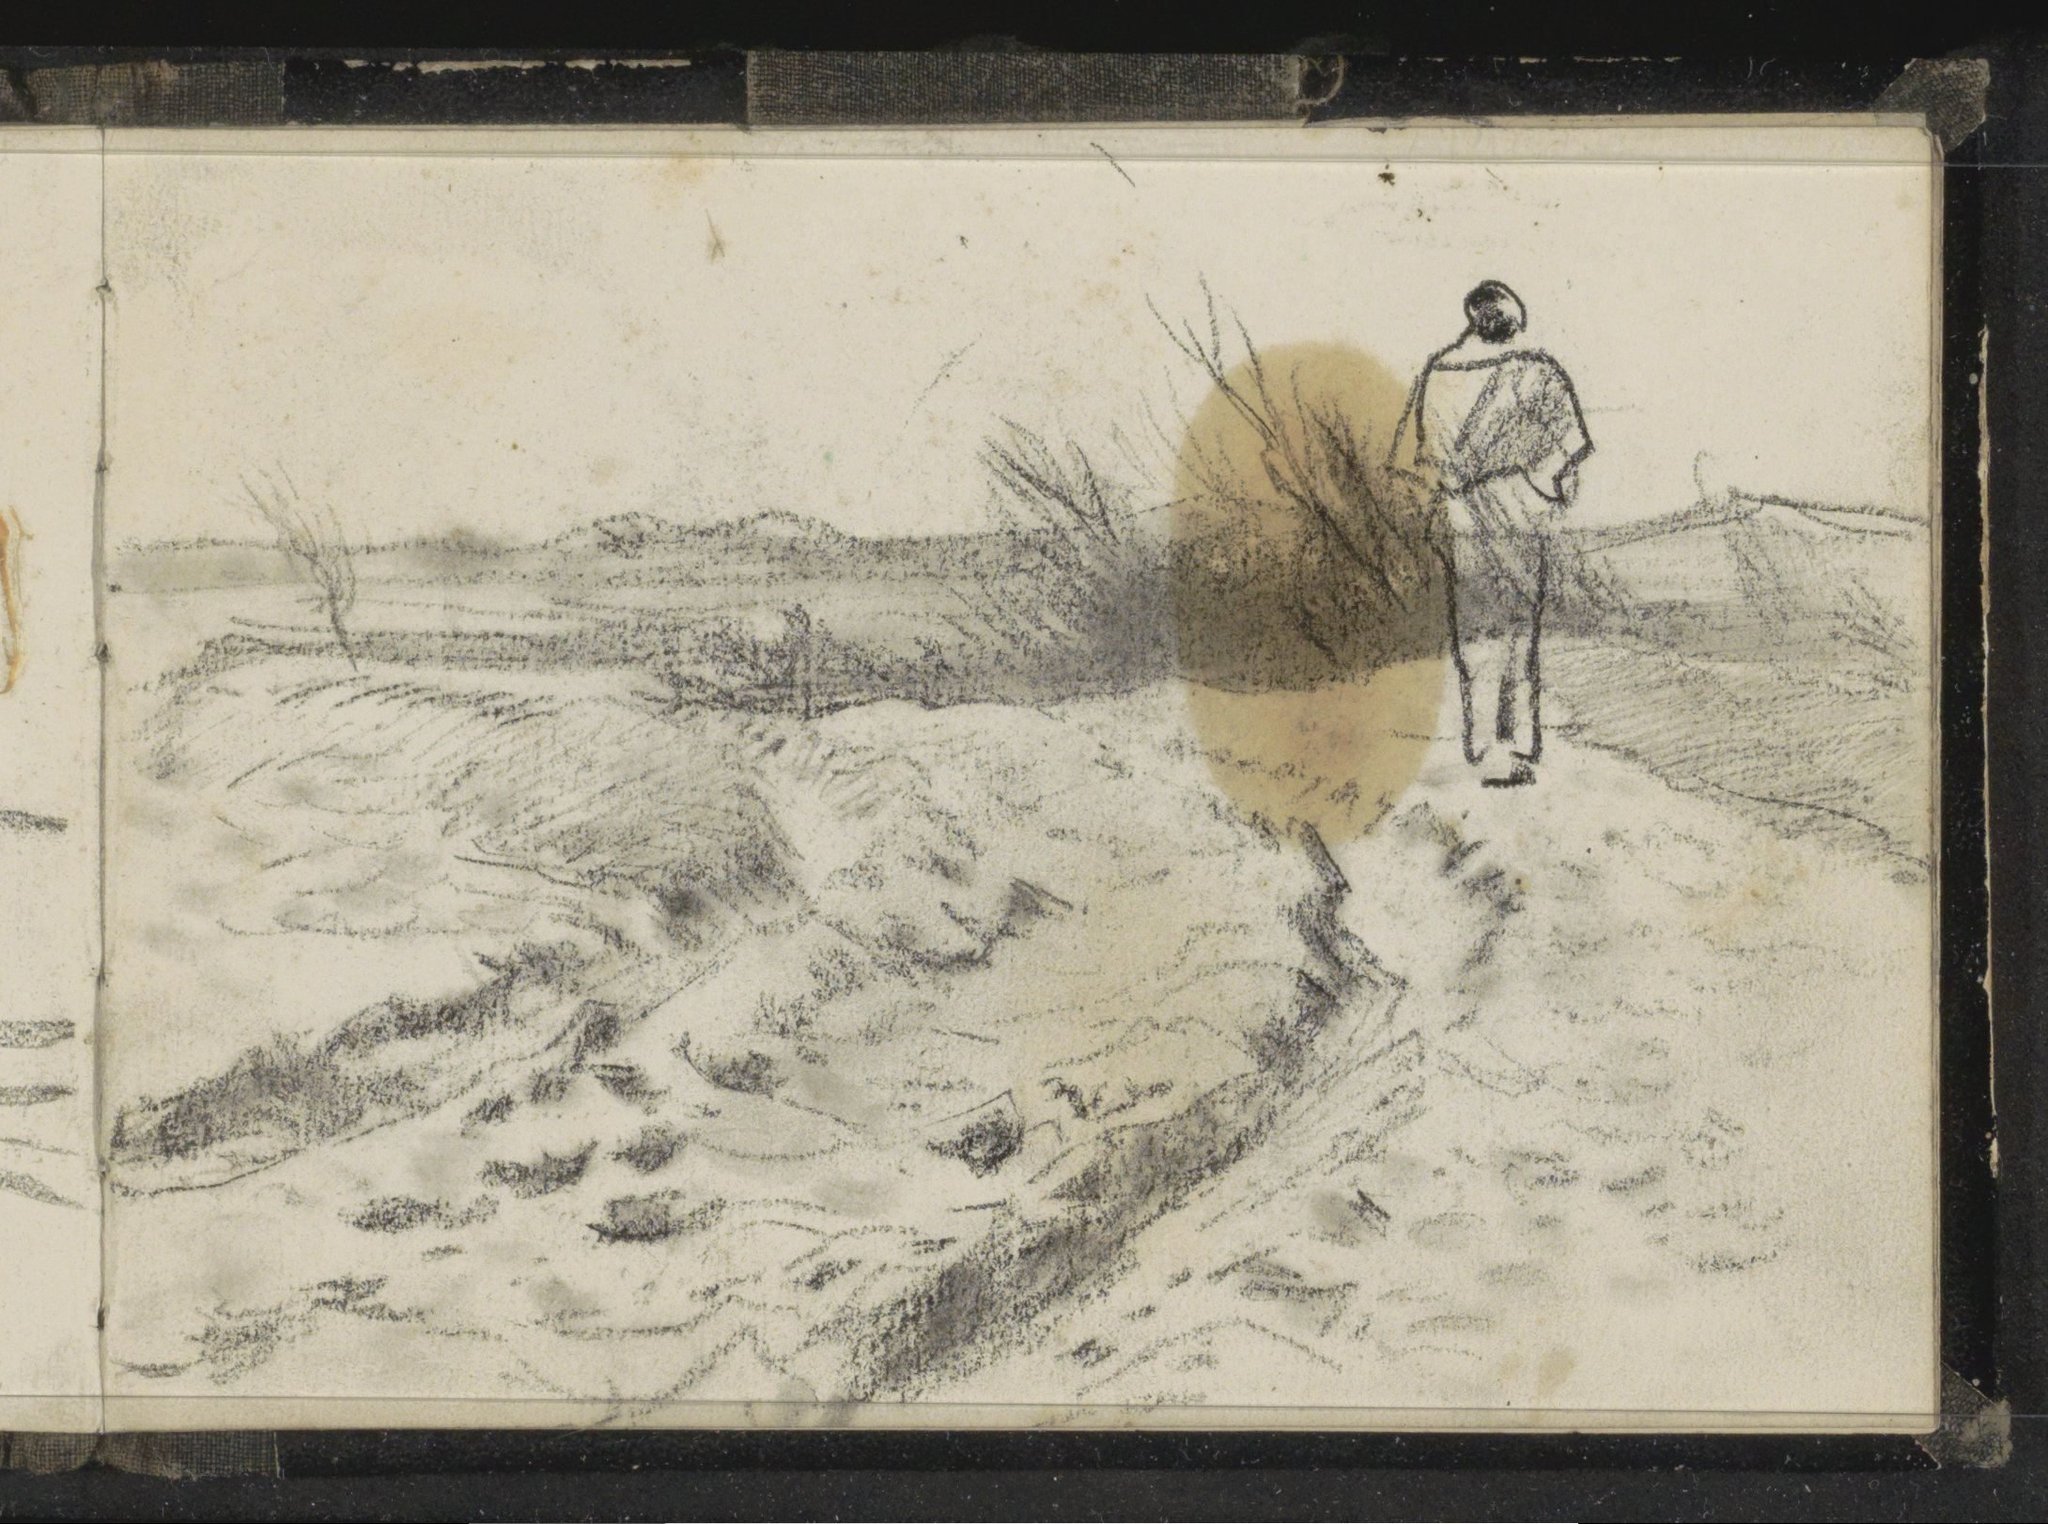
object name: sketchbook leaf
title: Heidelandschap met een figuur op een pad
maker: anton mauve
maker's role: draughtsman, painter, print maker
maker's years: 1838-1888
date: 1848-1888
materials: chalk, paper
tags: road, path, landscapes (+ landscape with figures, staffage)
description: Blad 31 recto uit een schetsboek met 33 bladen.